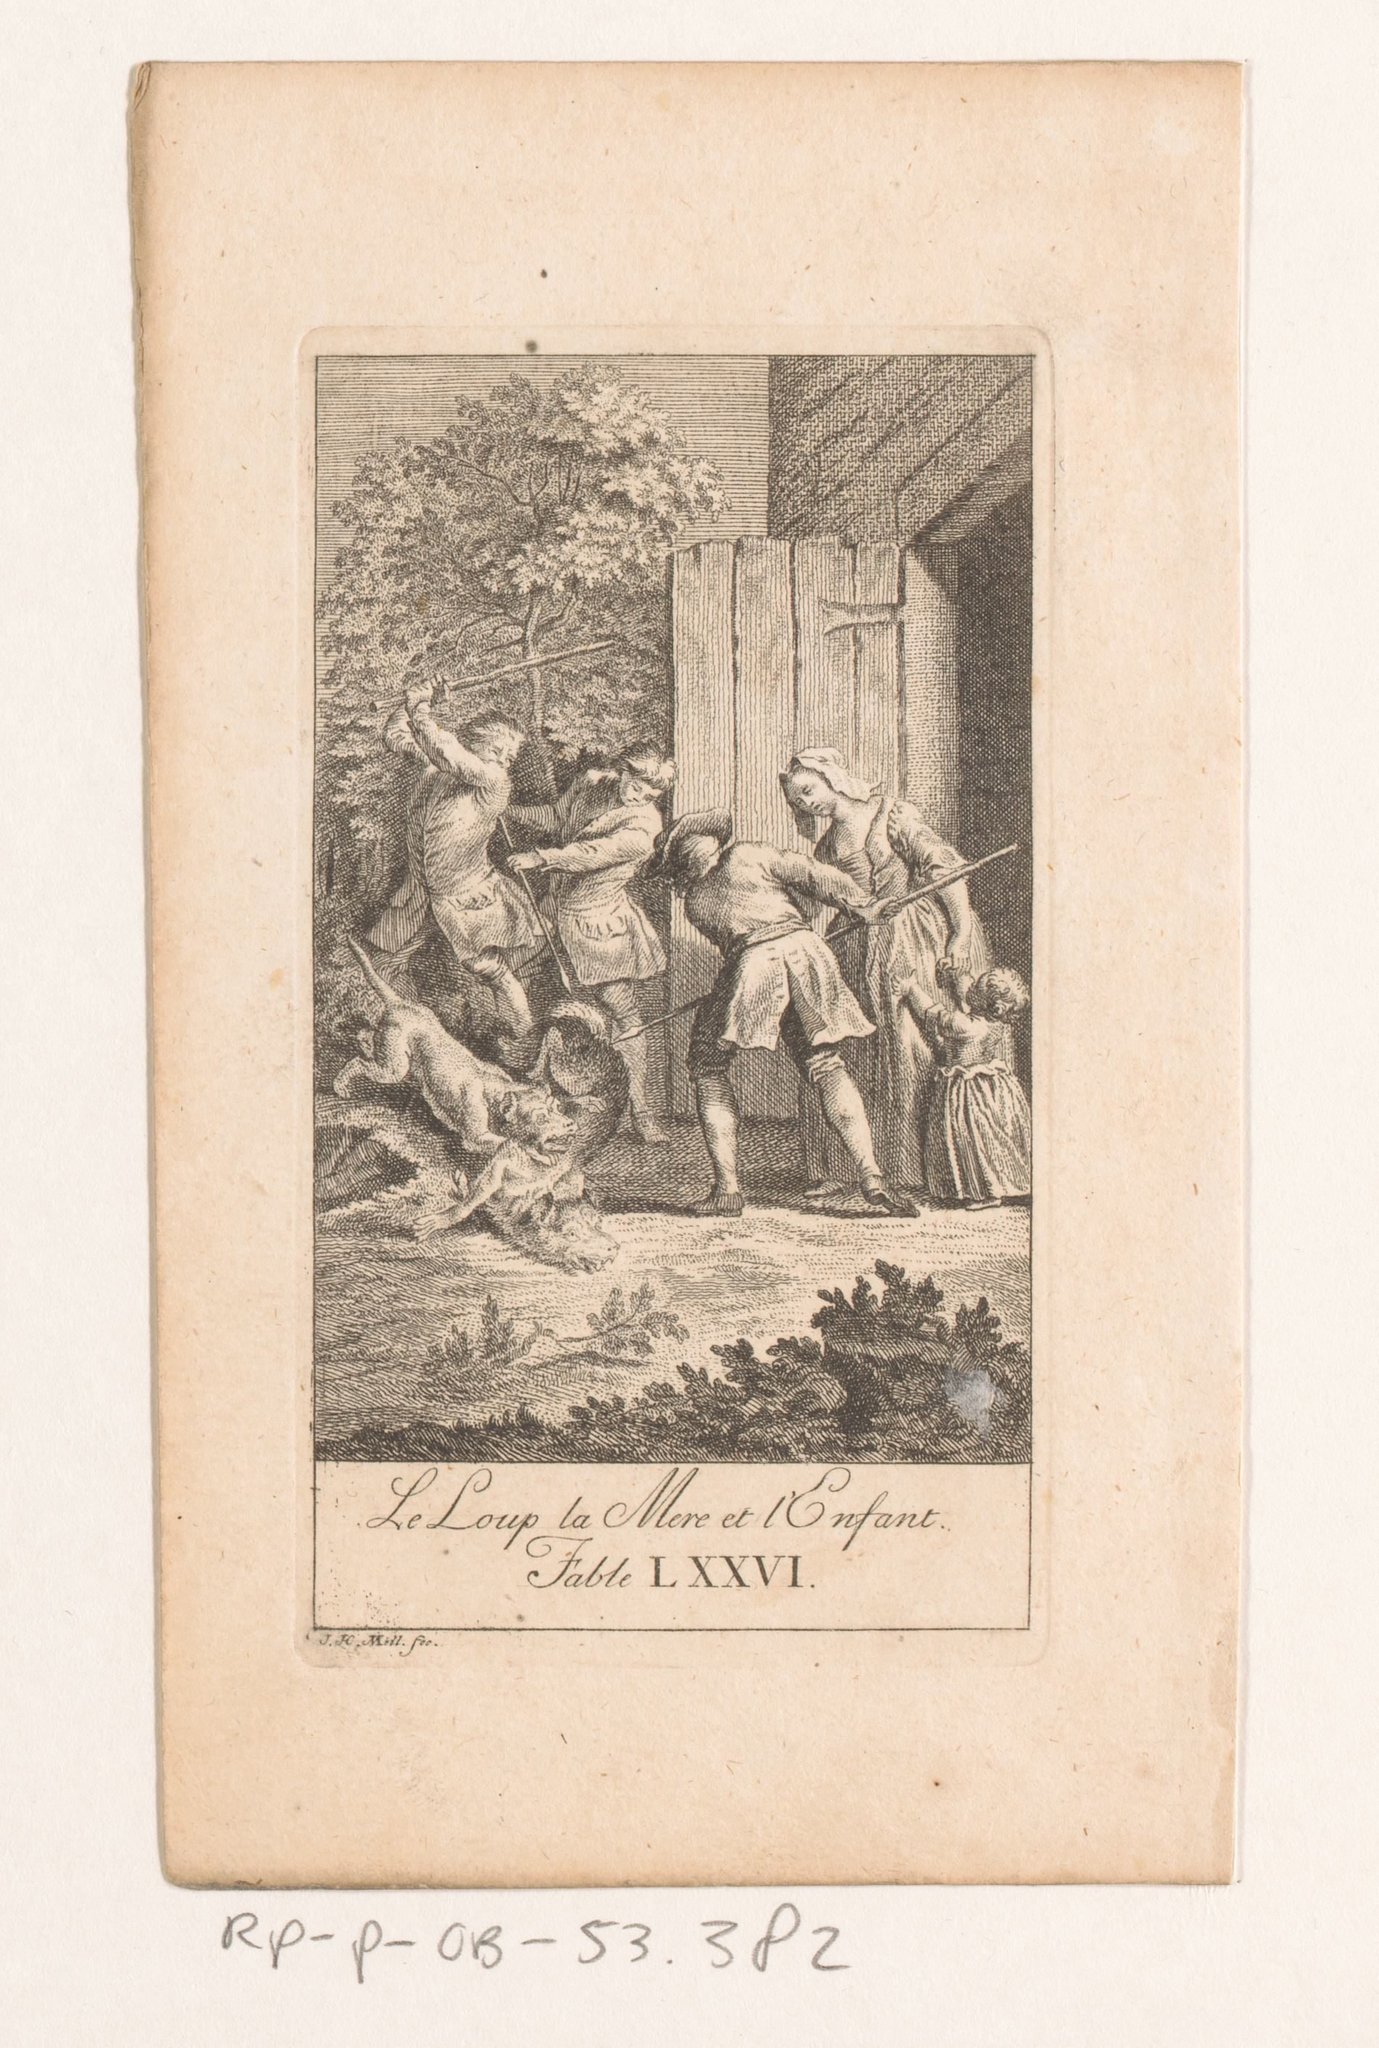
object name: print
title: Fabel van de wolf, de moeder en het kind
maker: johann heinrich meil (der ältere)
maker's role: print maker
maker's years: 1730-1820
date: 1758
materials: paper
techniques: etching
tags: fables of lafontaine : use 85(...), violent death by blows, kicks, pricks, etc., mother and baby or young child, fables of lafontaine (with title) : use 85(...), beasts of prey, predatory animals: wolf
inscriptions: collector's mark: Lugt 2228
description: Illustratie uit: Fontaine, J. de la. Fables choisies, mises en vers. Dl. 2. Dresden & Leipzig: George Conrad Walther, 1758.